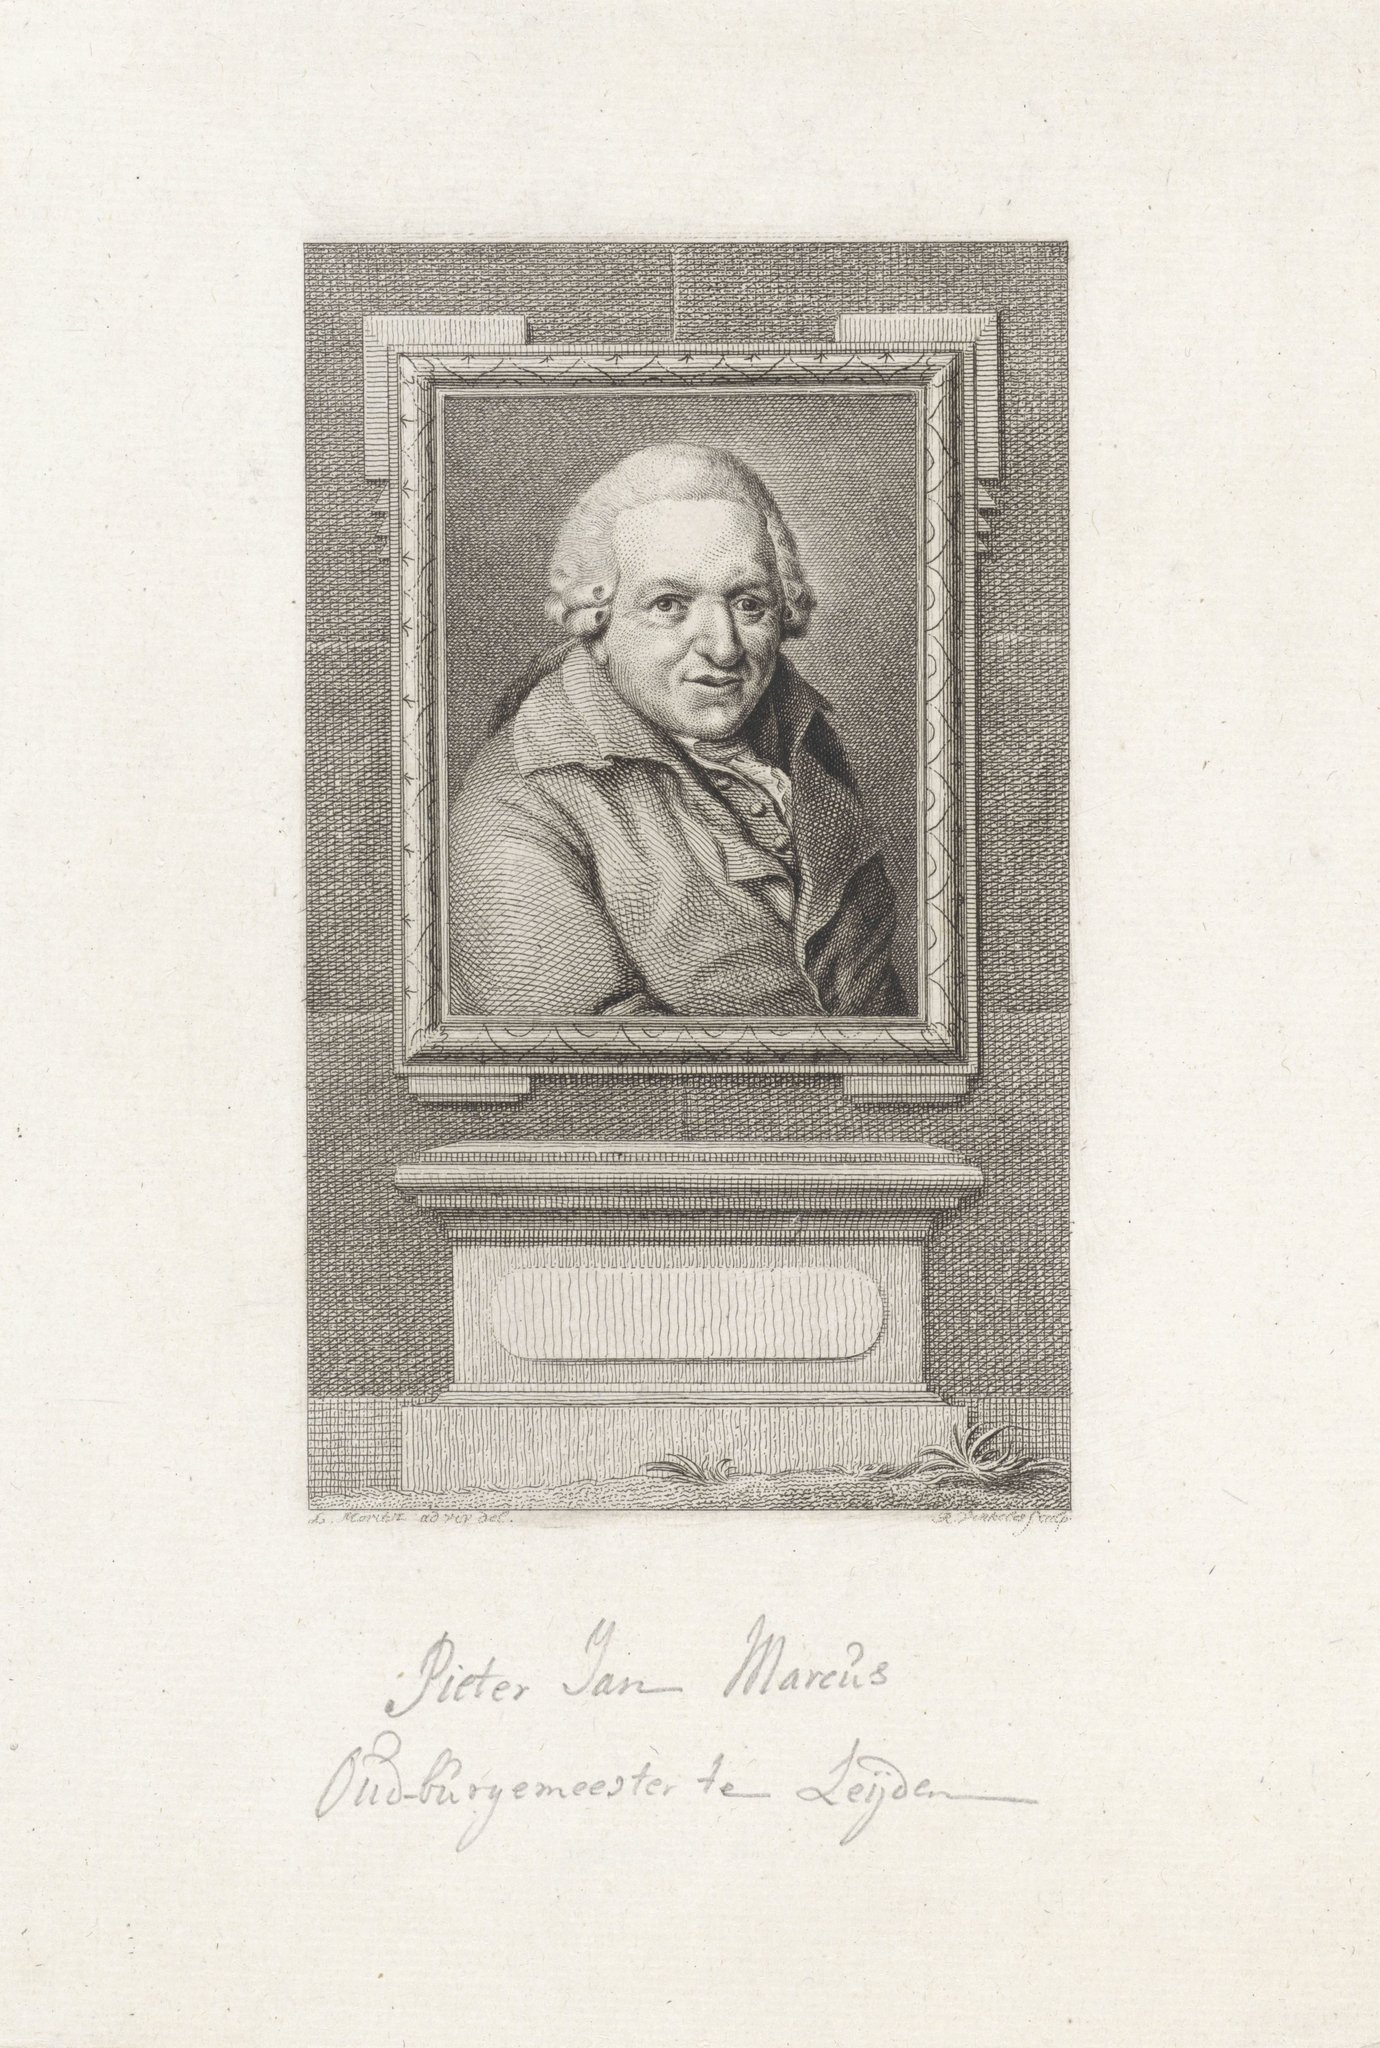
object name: print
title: Portret van Pieter Jan Marcus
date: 1786-1809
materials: paper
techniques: etching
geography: amsterdam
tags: pieter jan marcus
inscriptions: collector's mark: Lugt 240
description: Latere staat prent ook gebruikt als boekillustratie in: Wagenaar, Jan. Vaderlandsche historie, (...) ten vervolge van Wagenaars Vaderlandsche historie. Dl. 1-43. Amsterdam: Johannes Allart, 1786-1809.